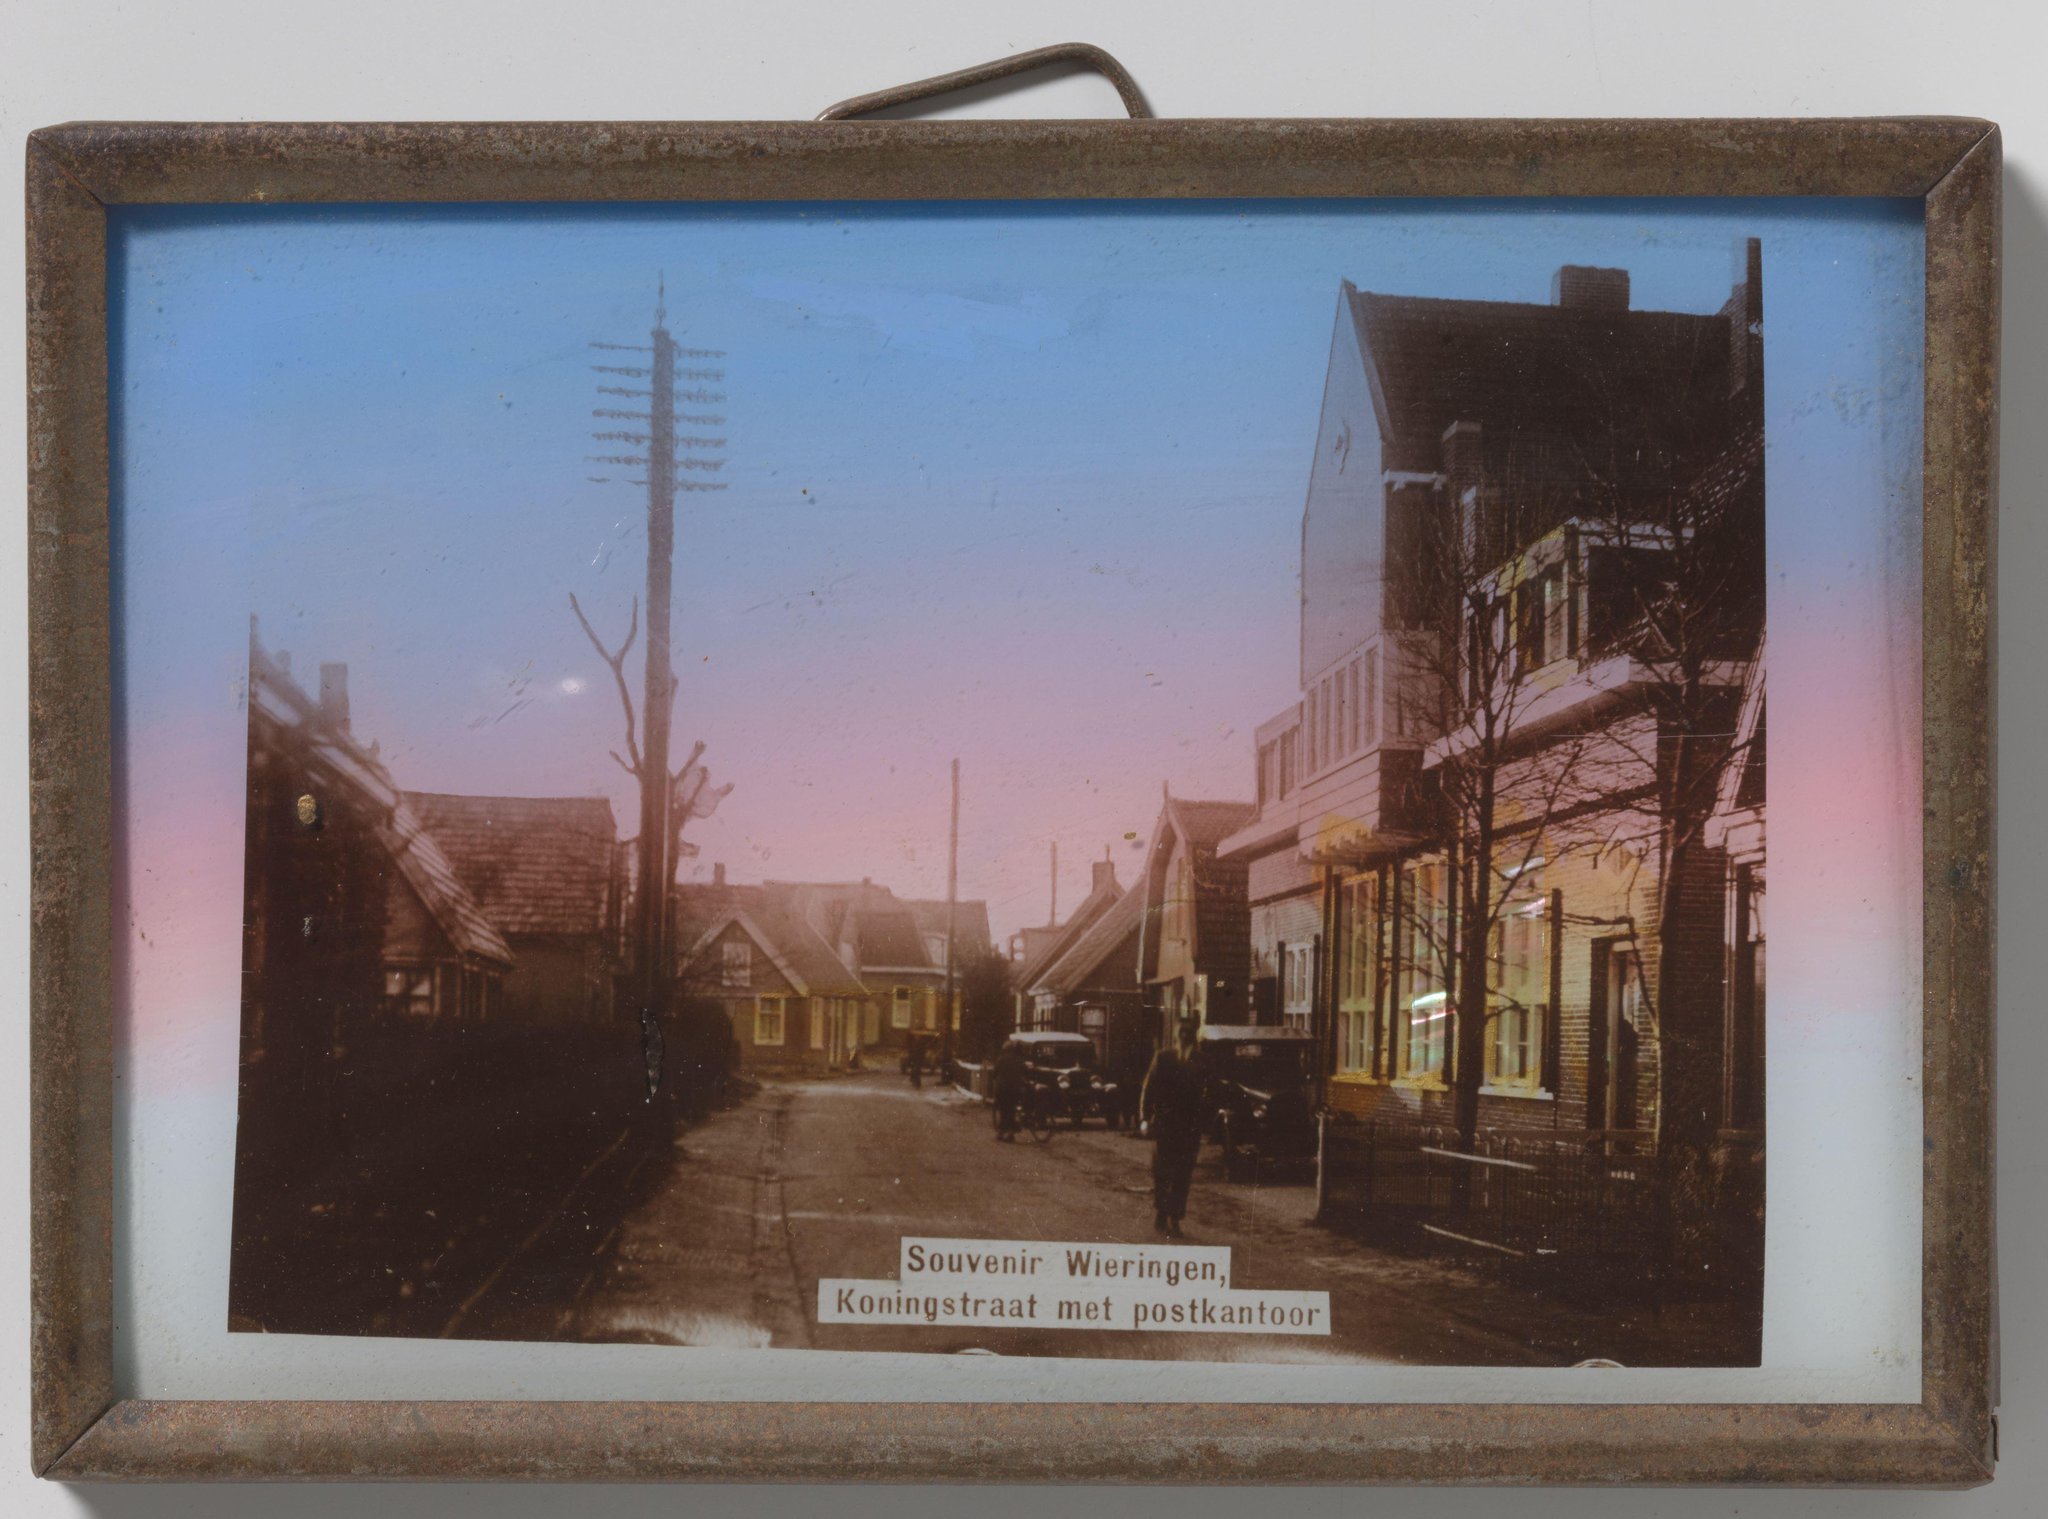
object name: frame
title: Gezicht op de Koningstraat in Wieringen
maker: Anonymous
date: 1920-1950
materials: paper, cardboard, glass, metal, mother of pearl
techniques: gelatin silver print, inlay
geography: wieringen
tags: post-office, street